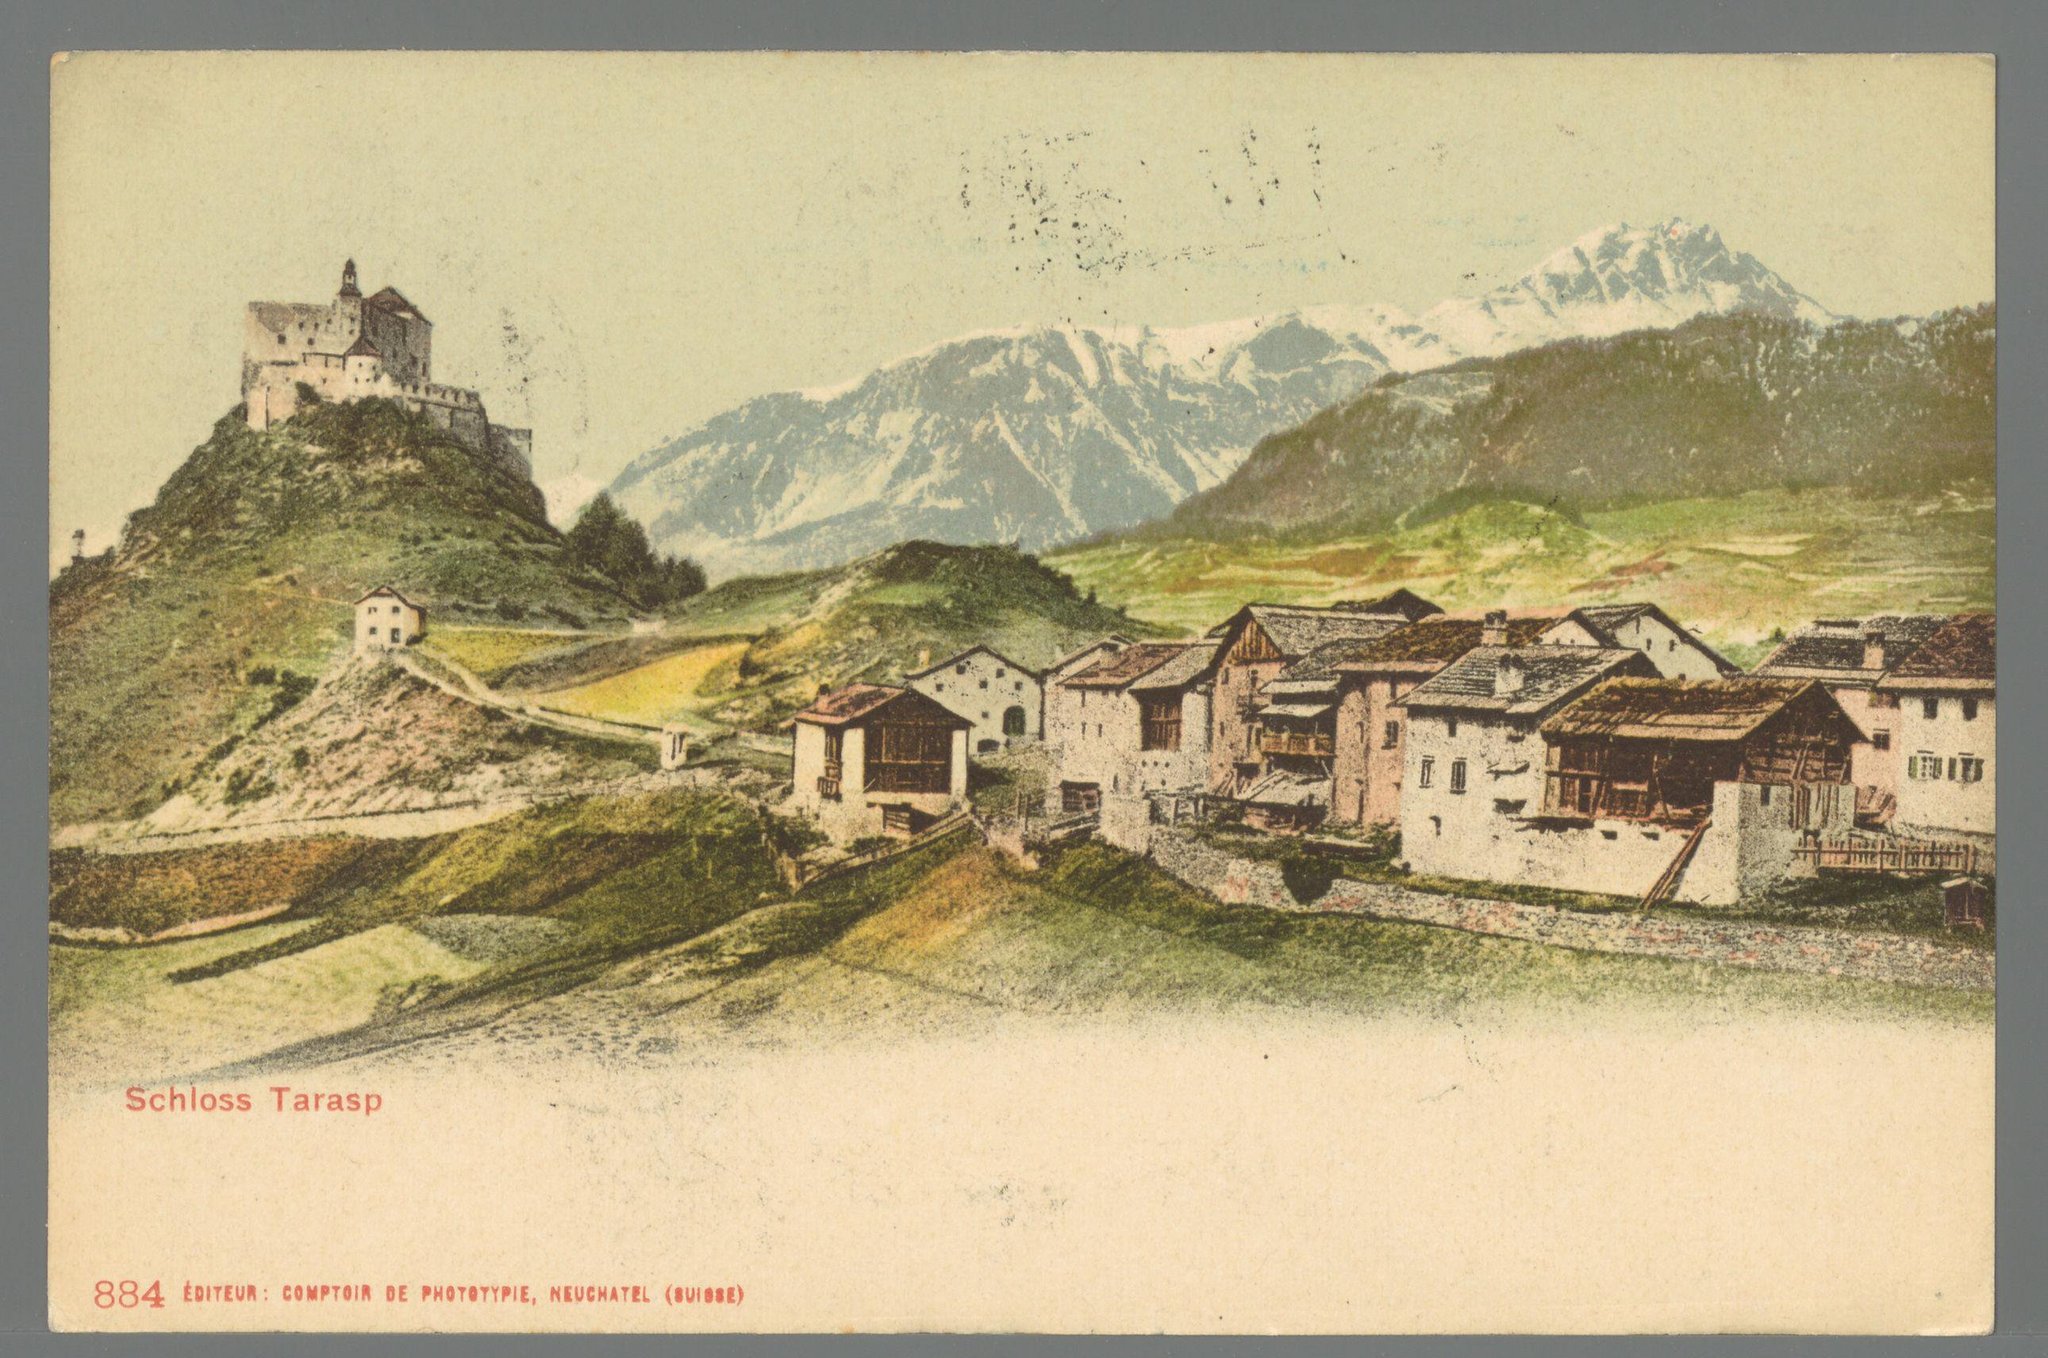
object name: photomechanical print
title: Schloss Tarasp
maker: Anonymous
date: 1898-1903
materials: cardboard, photographic process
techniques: writing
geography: scuol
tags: castle, village, mountain-range, snow peaks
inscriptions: postage stamp